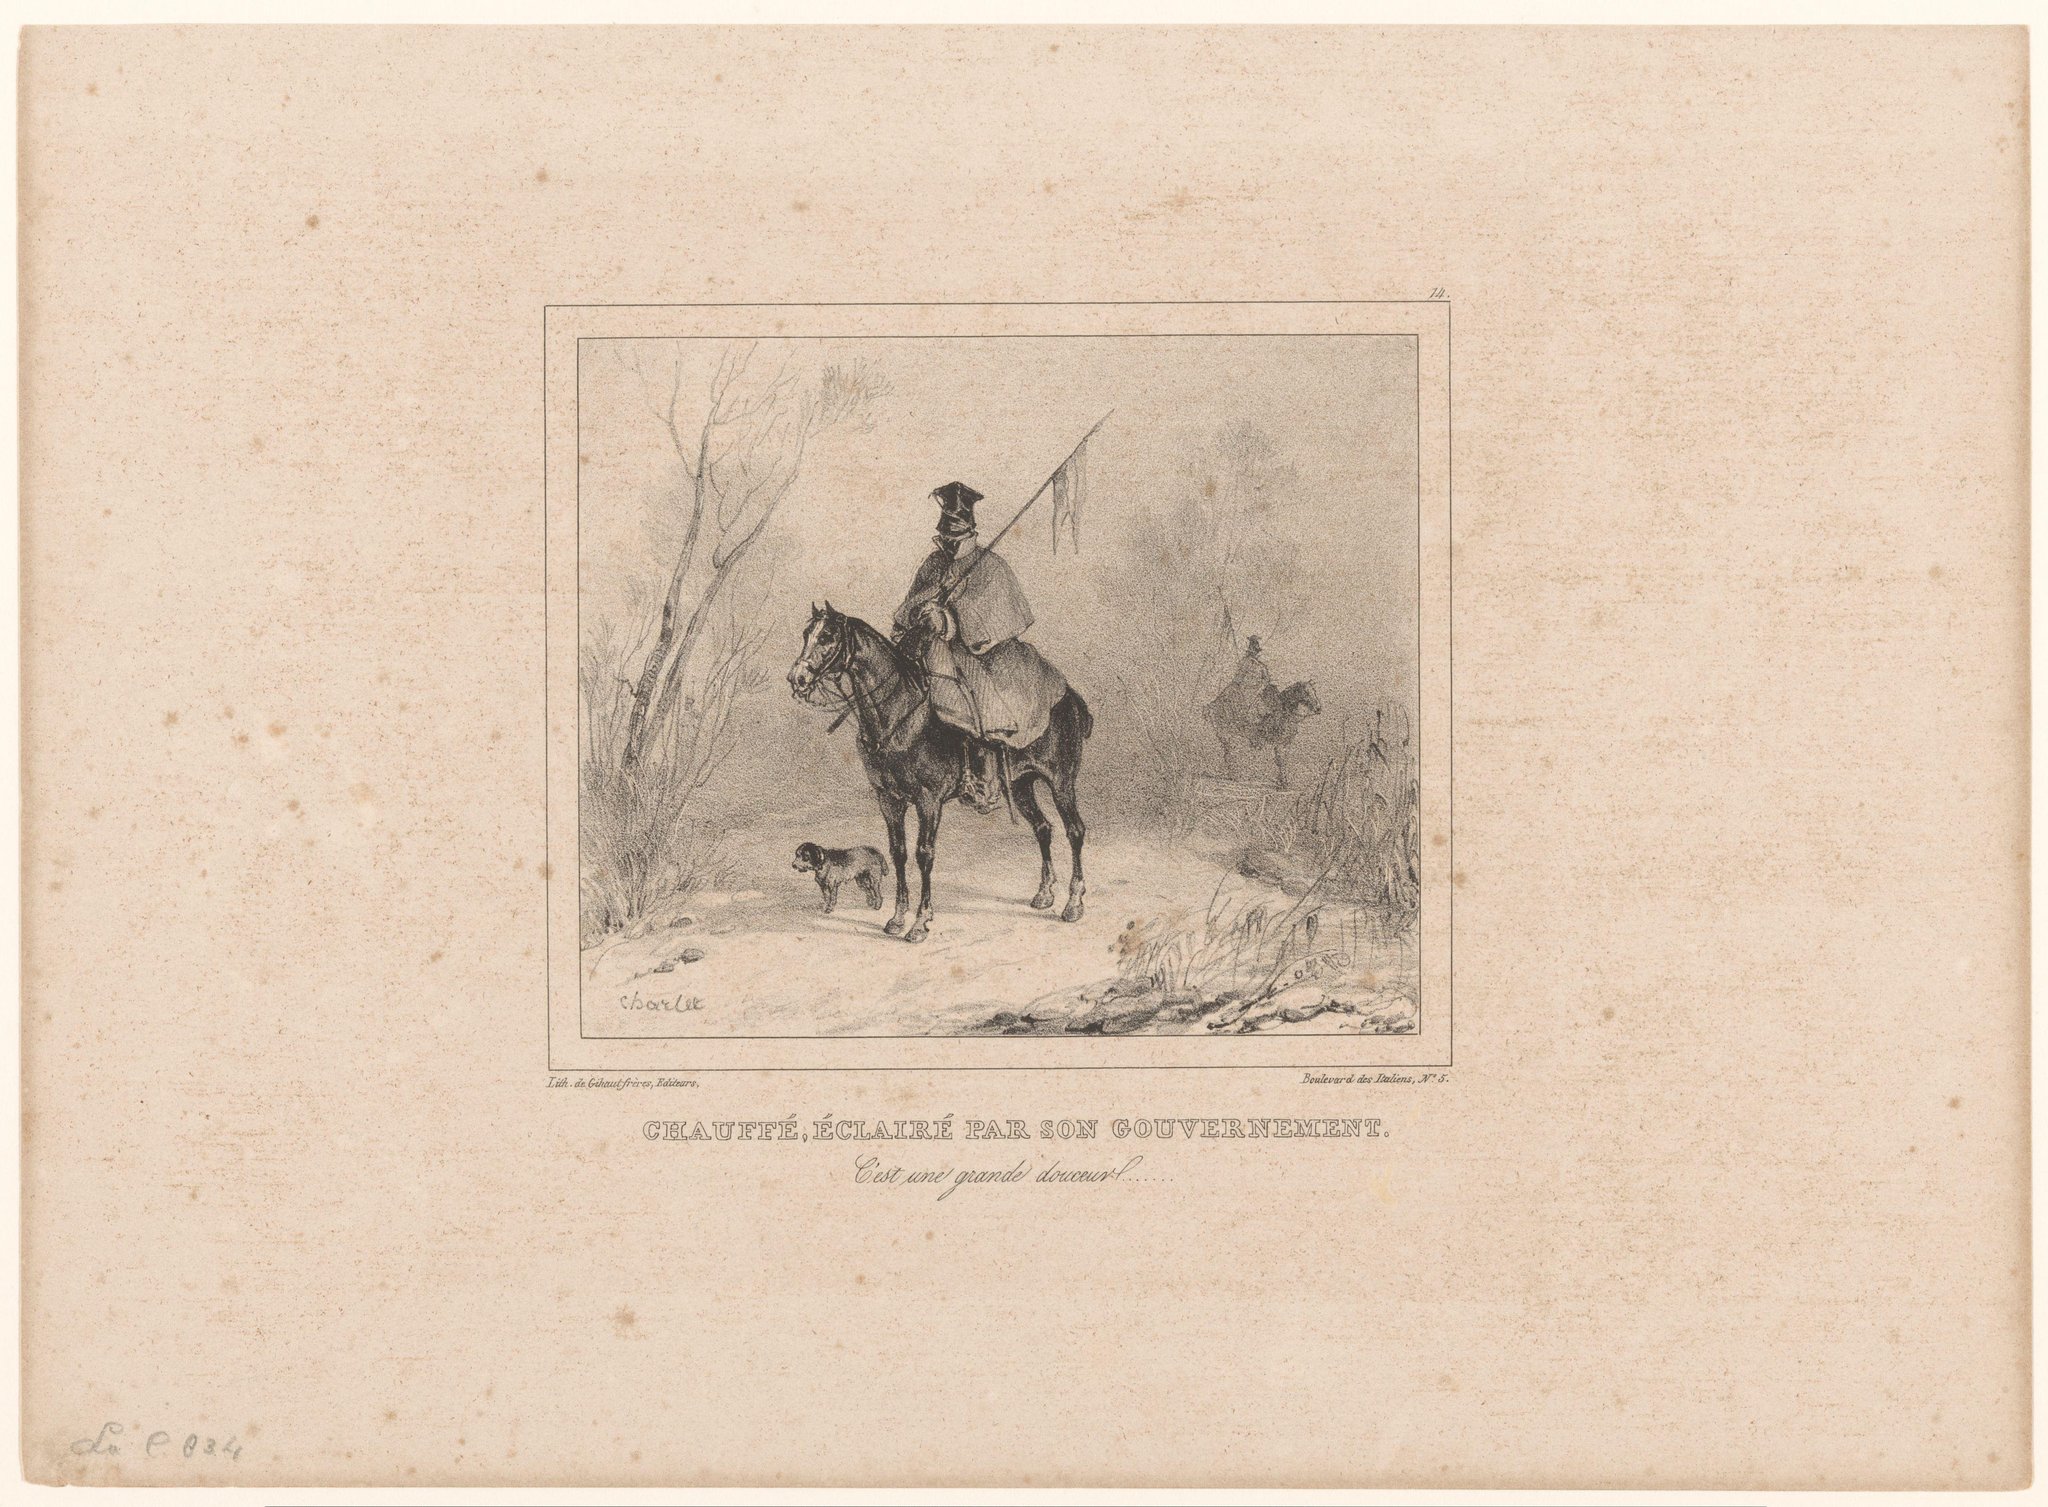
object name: print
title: Twee militairen te paard houden de wacht in de sneeuw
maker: nicolas toussaint charlet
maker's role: draughtsman, painter, print maker, printer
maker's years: 1792-1845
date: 1834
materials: paper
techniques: lithograph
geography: paris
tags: snow, guard duty, keeping sentry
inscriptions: collector's mark: Lugt 2228a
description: De tekst onder de afbeelding zegt dat het een grote troost voor de militair is dat hij wordt verwarmd en verlicht door zijn regering.